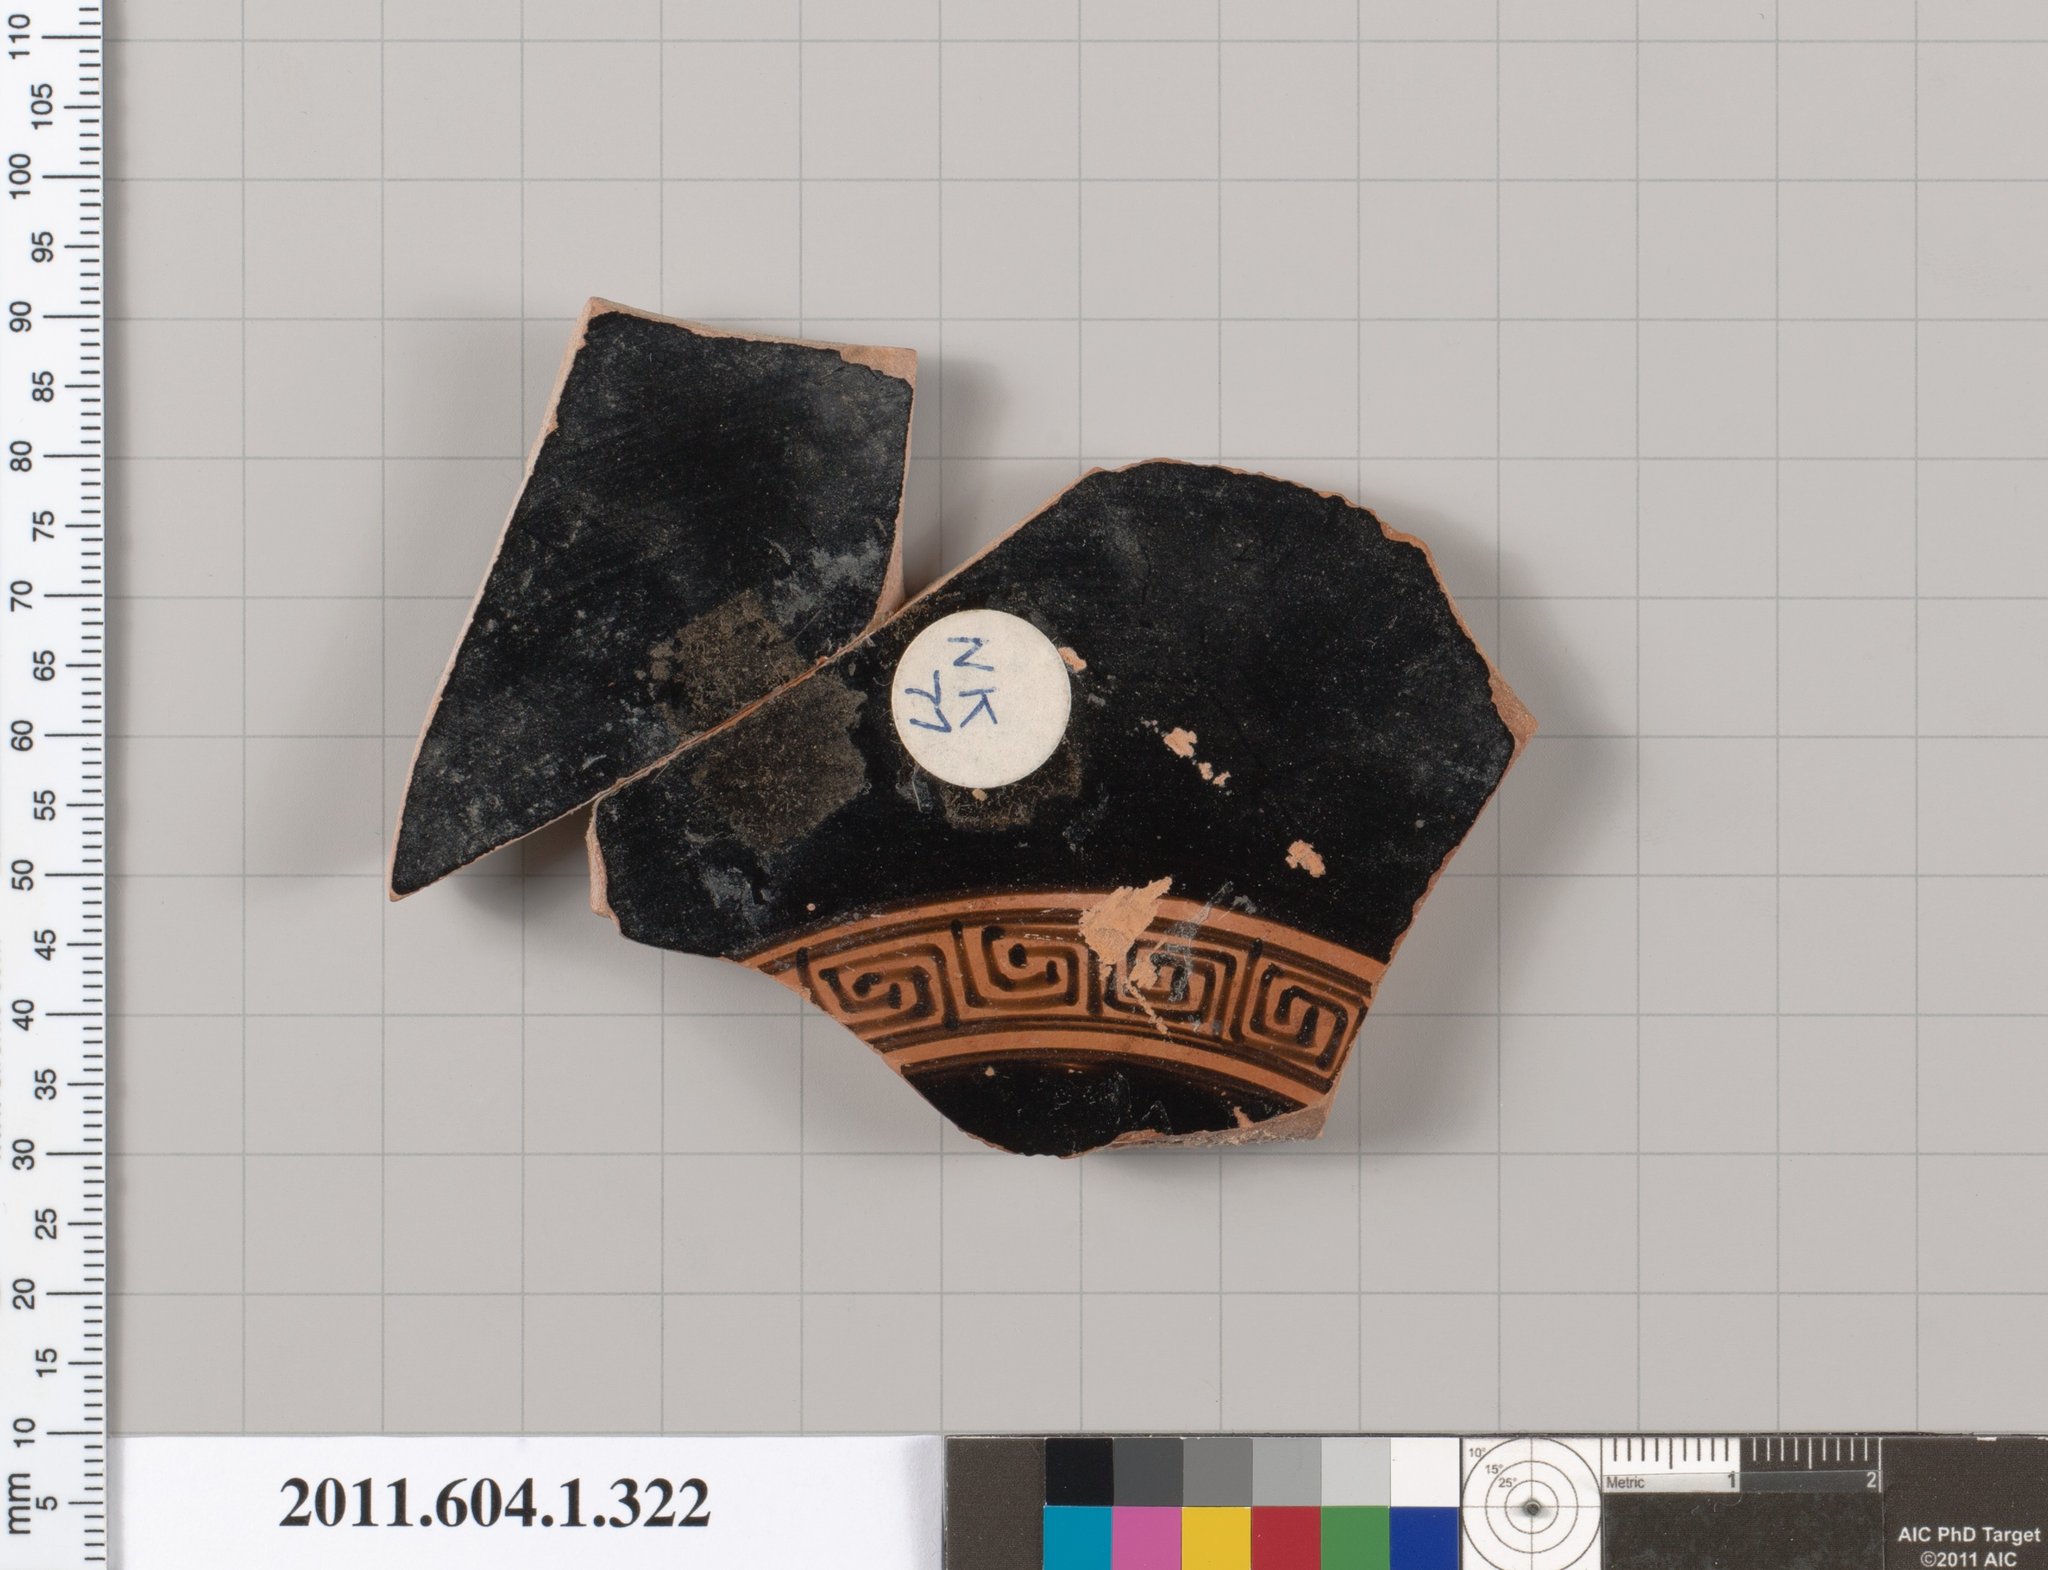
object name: kylix fragment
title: Terracotta fragment of a kylix (drinking cup)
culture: greek, attic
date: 475-451 BCE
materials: terracotta